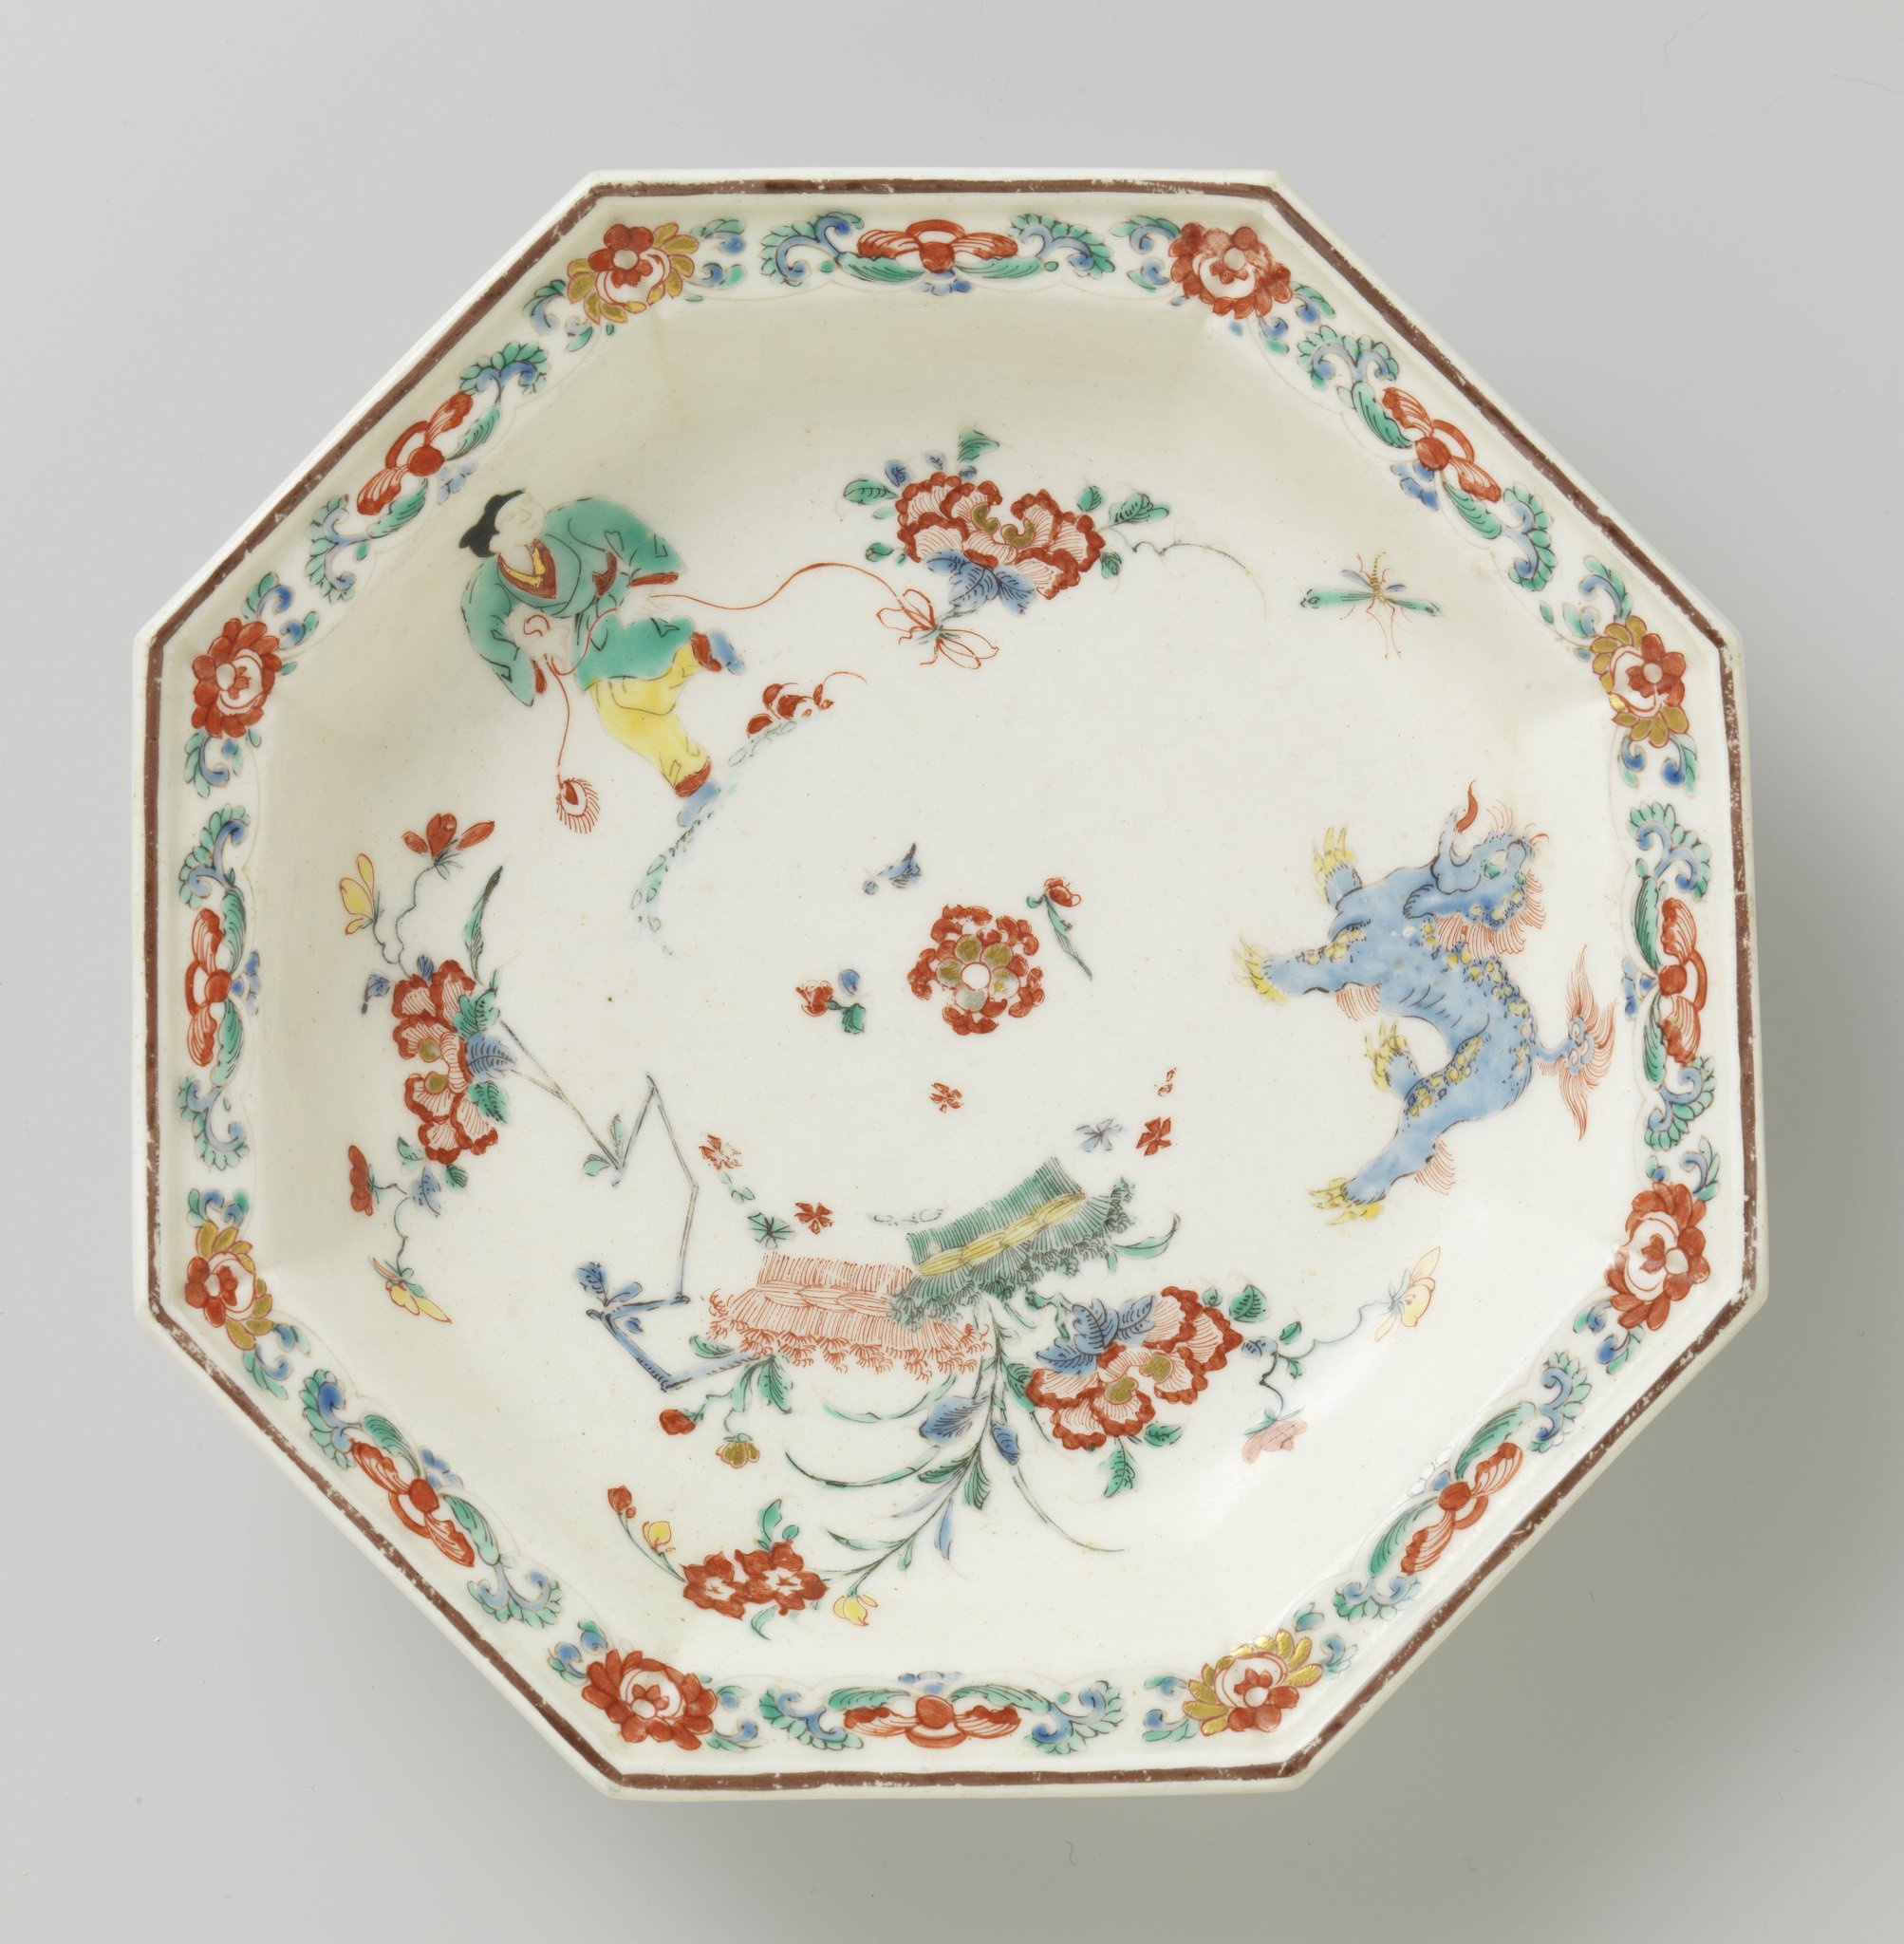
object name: plate dish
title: Plate with a boy, a shishi and flowerin plants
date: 1755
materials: glaze, gold, paint, porcelain, soft paste porcelain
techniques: firing, forming, gilding, turning, vitrification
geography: bow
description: Zeshoekig bord van soft-paste porselein (pâte tendre), beschilderd op het glazuur in blauw, rood, groen, geel, zwart en goud. Op de voorzijde in het centrum een bloemrank en strooibloemen. Hieromheen een jongen met een bloemtak aan een touw, bloeiende planten (pioen) achter heggen en een shishi. De rand met een bladrank. Bruine rand. Het bord is in de stijl van het Japanse Kakiemon porselein.